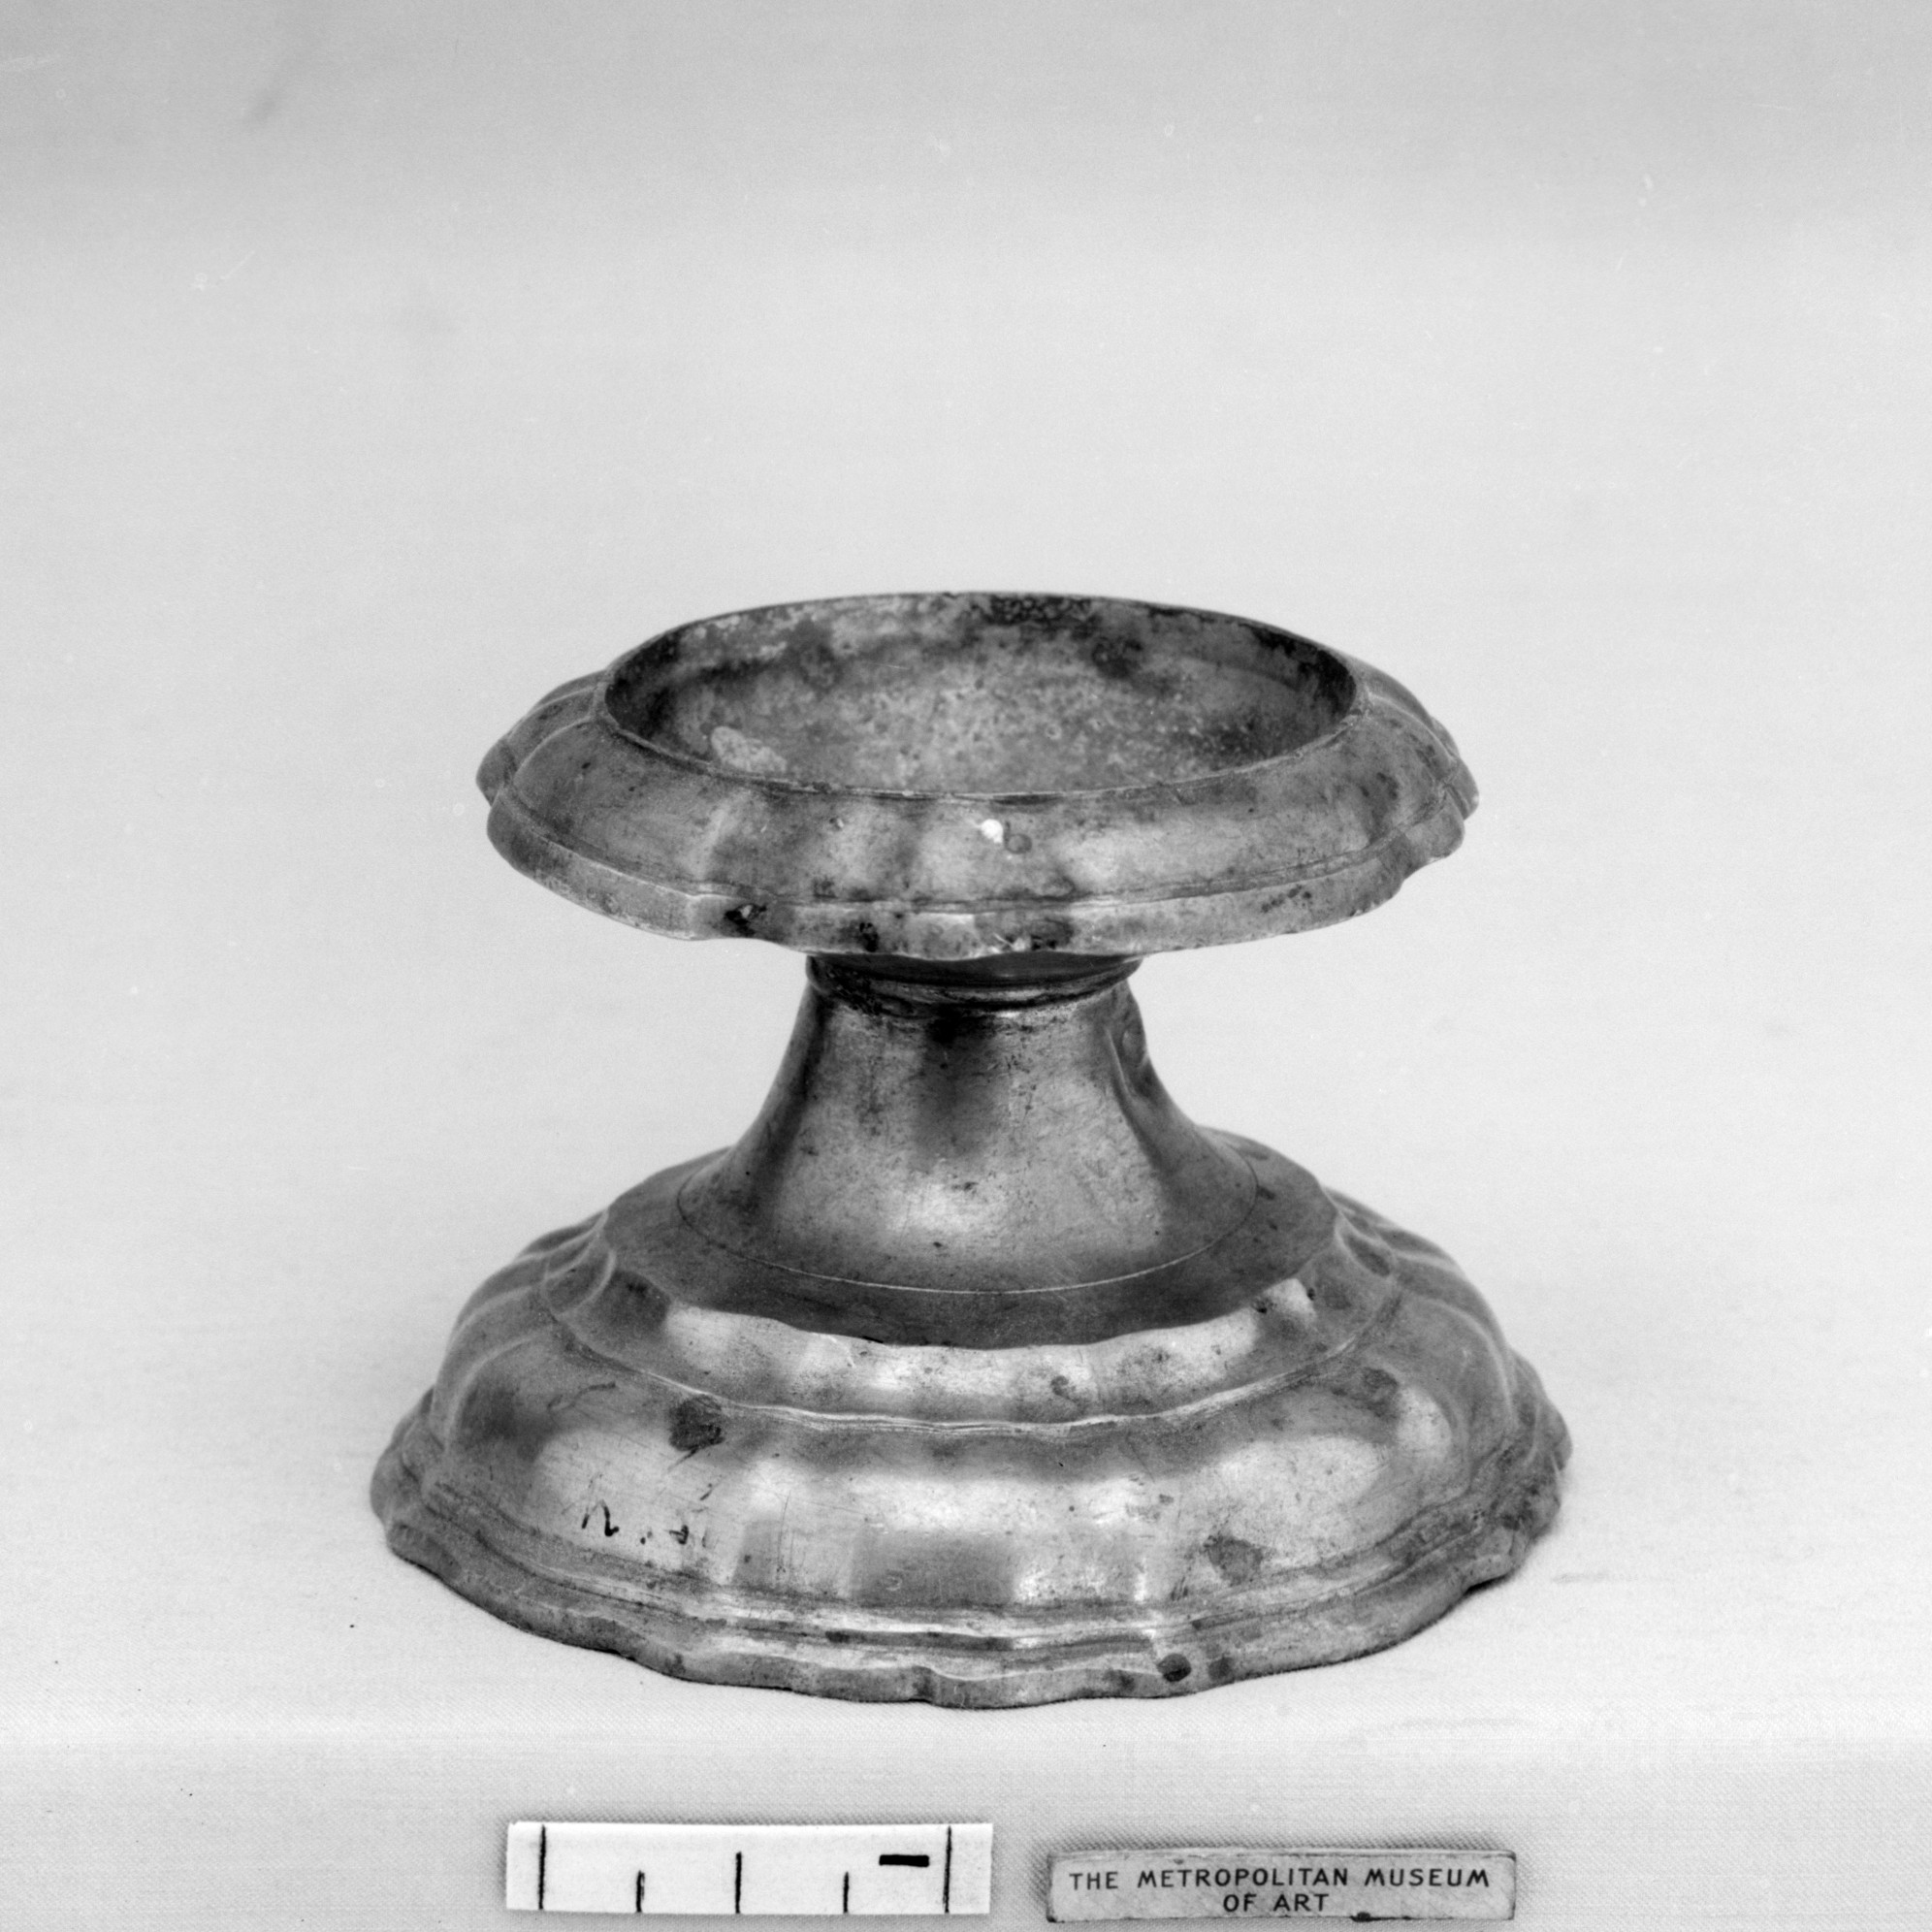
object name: saltcellar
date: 1701-1800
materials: pewter